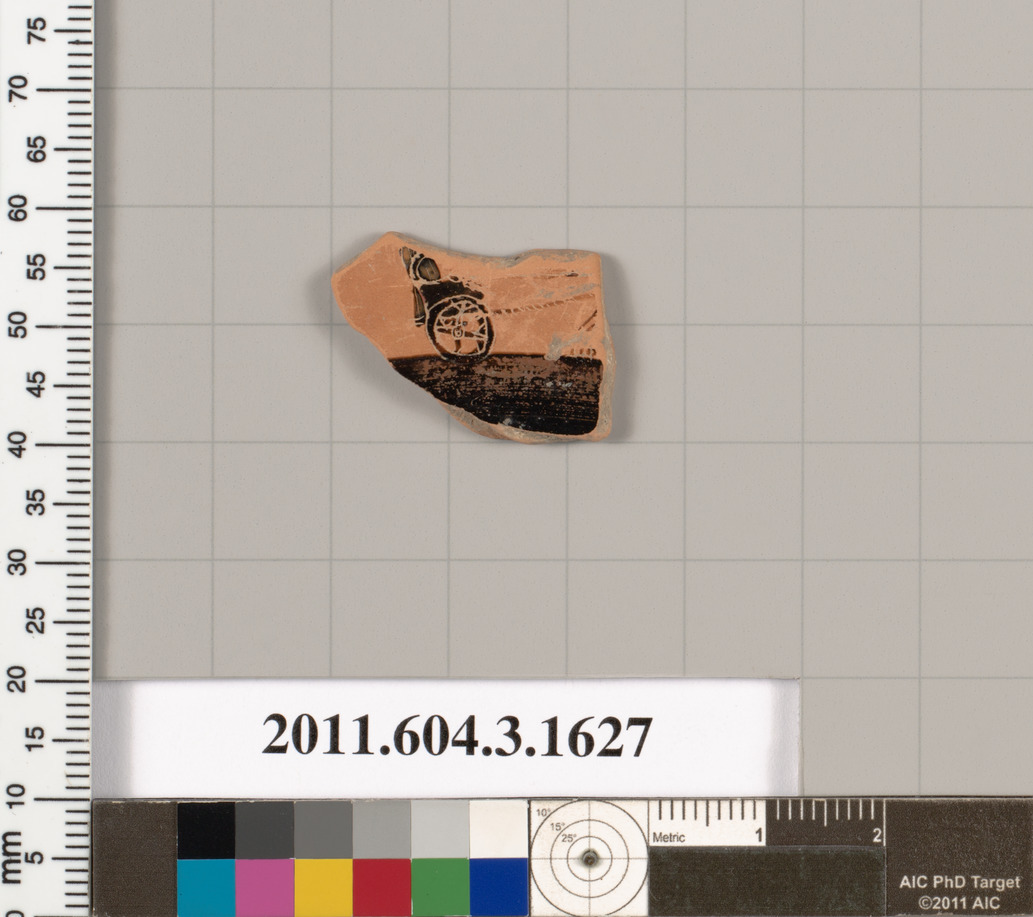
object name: kylix fragment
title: Terracotta fragment of a kylix: Band cup (drinking cup)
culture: greek, attic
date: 567-535 BCE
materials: terracotta